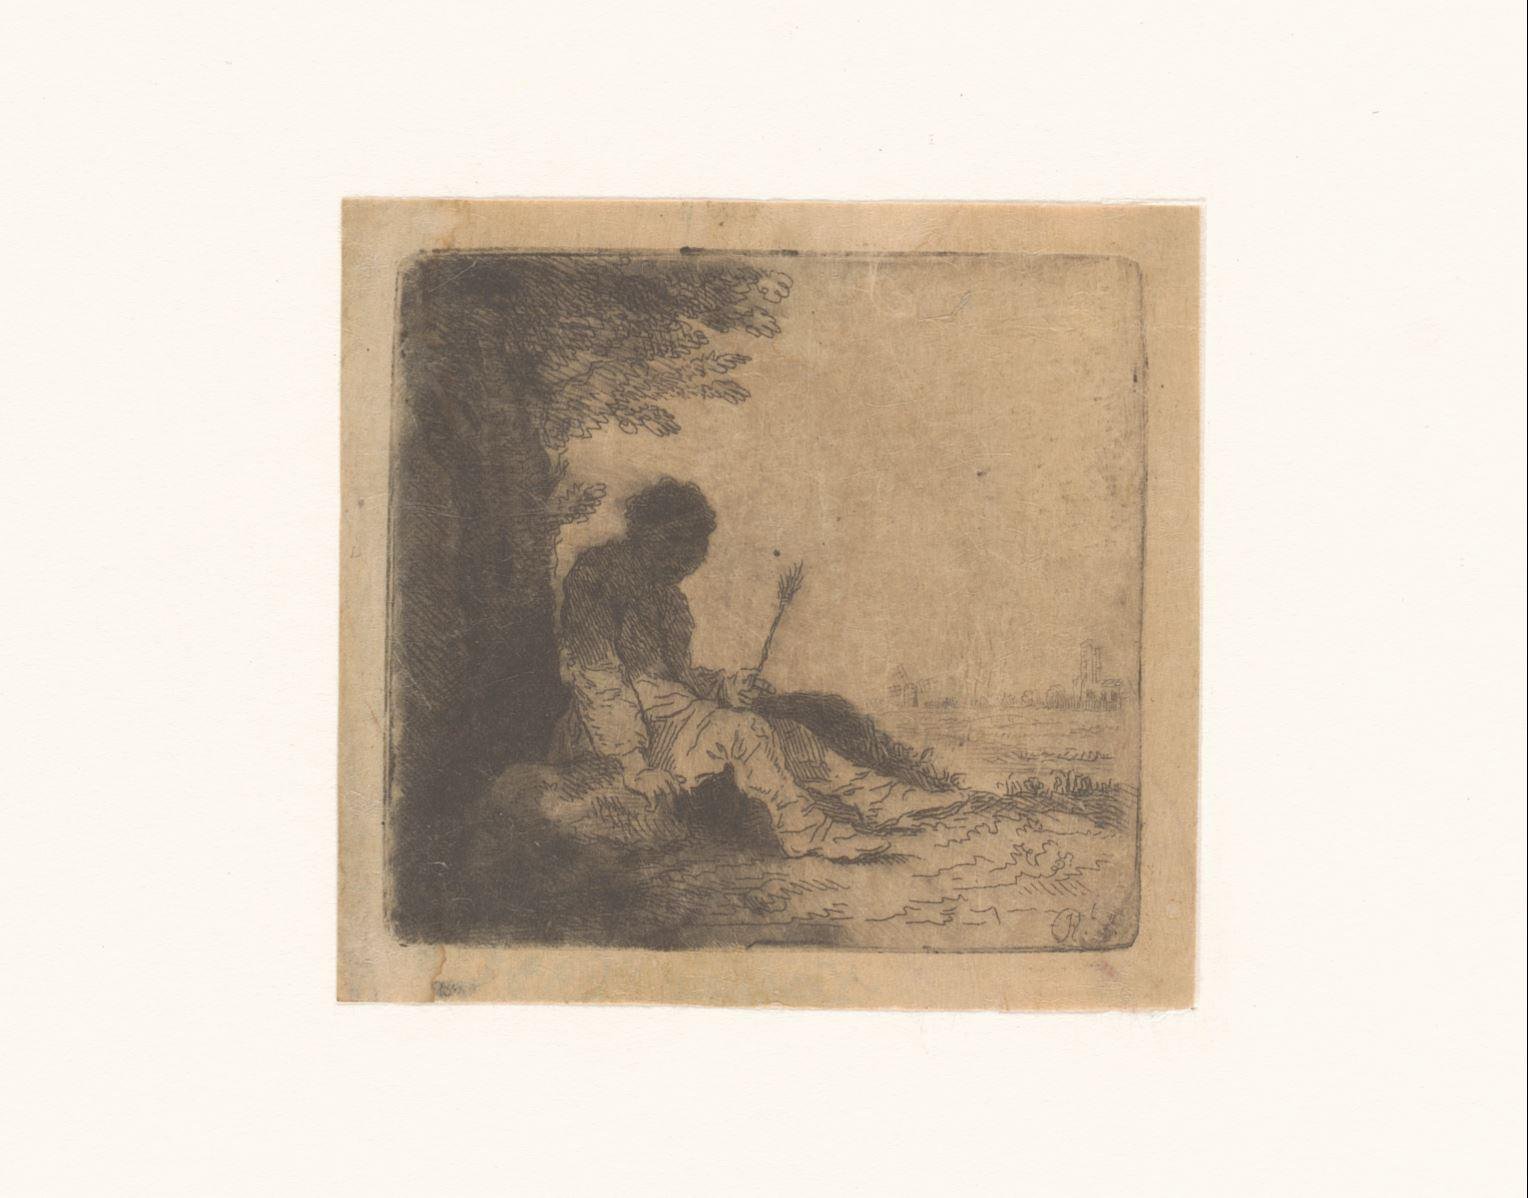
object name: print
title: Man rust onder een boom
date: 1778-1781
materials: paper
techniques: etching, intaglio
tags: resting - bb - out of doors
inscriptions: collector's mark: Lugt 240